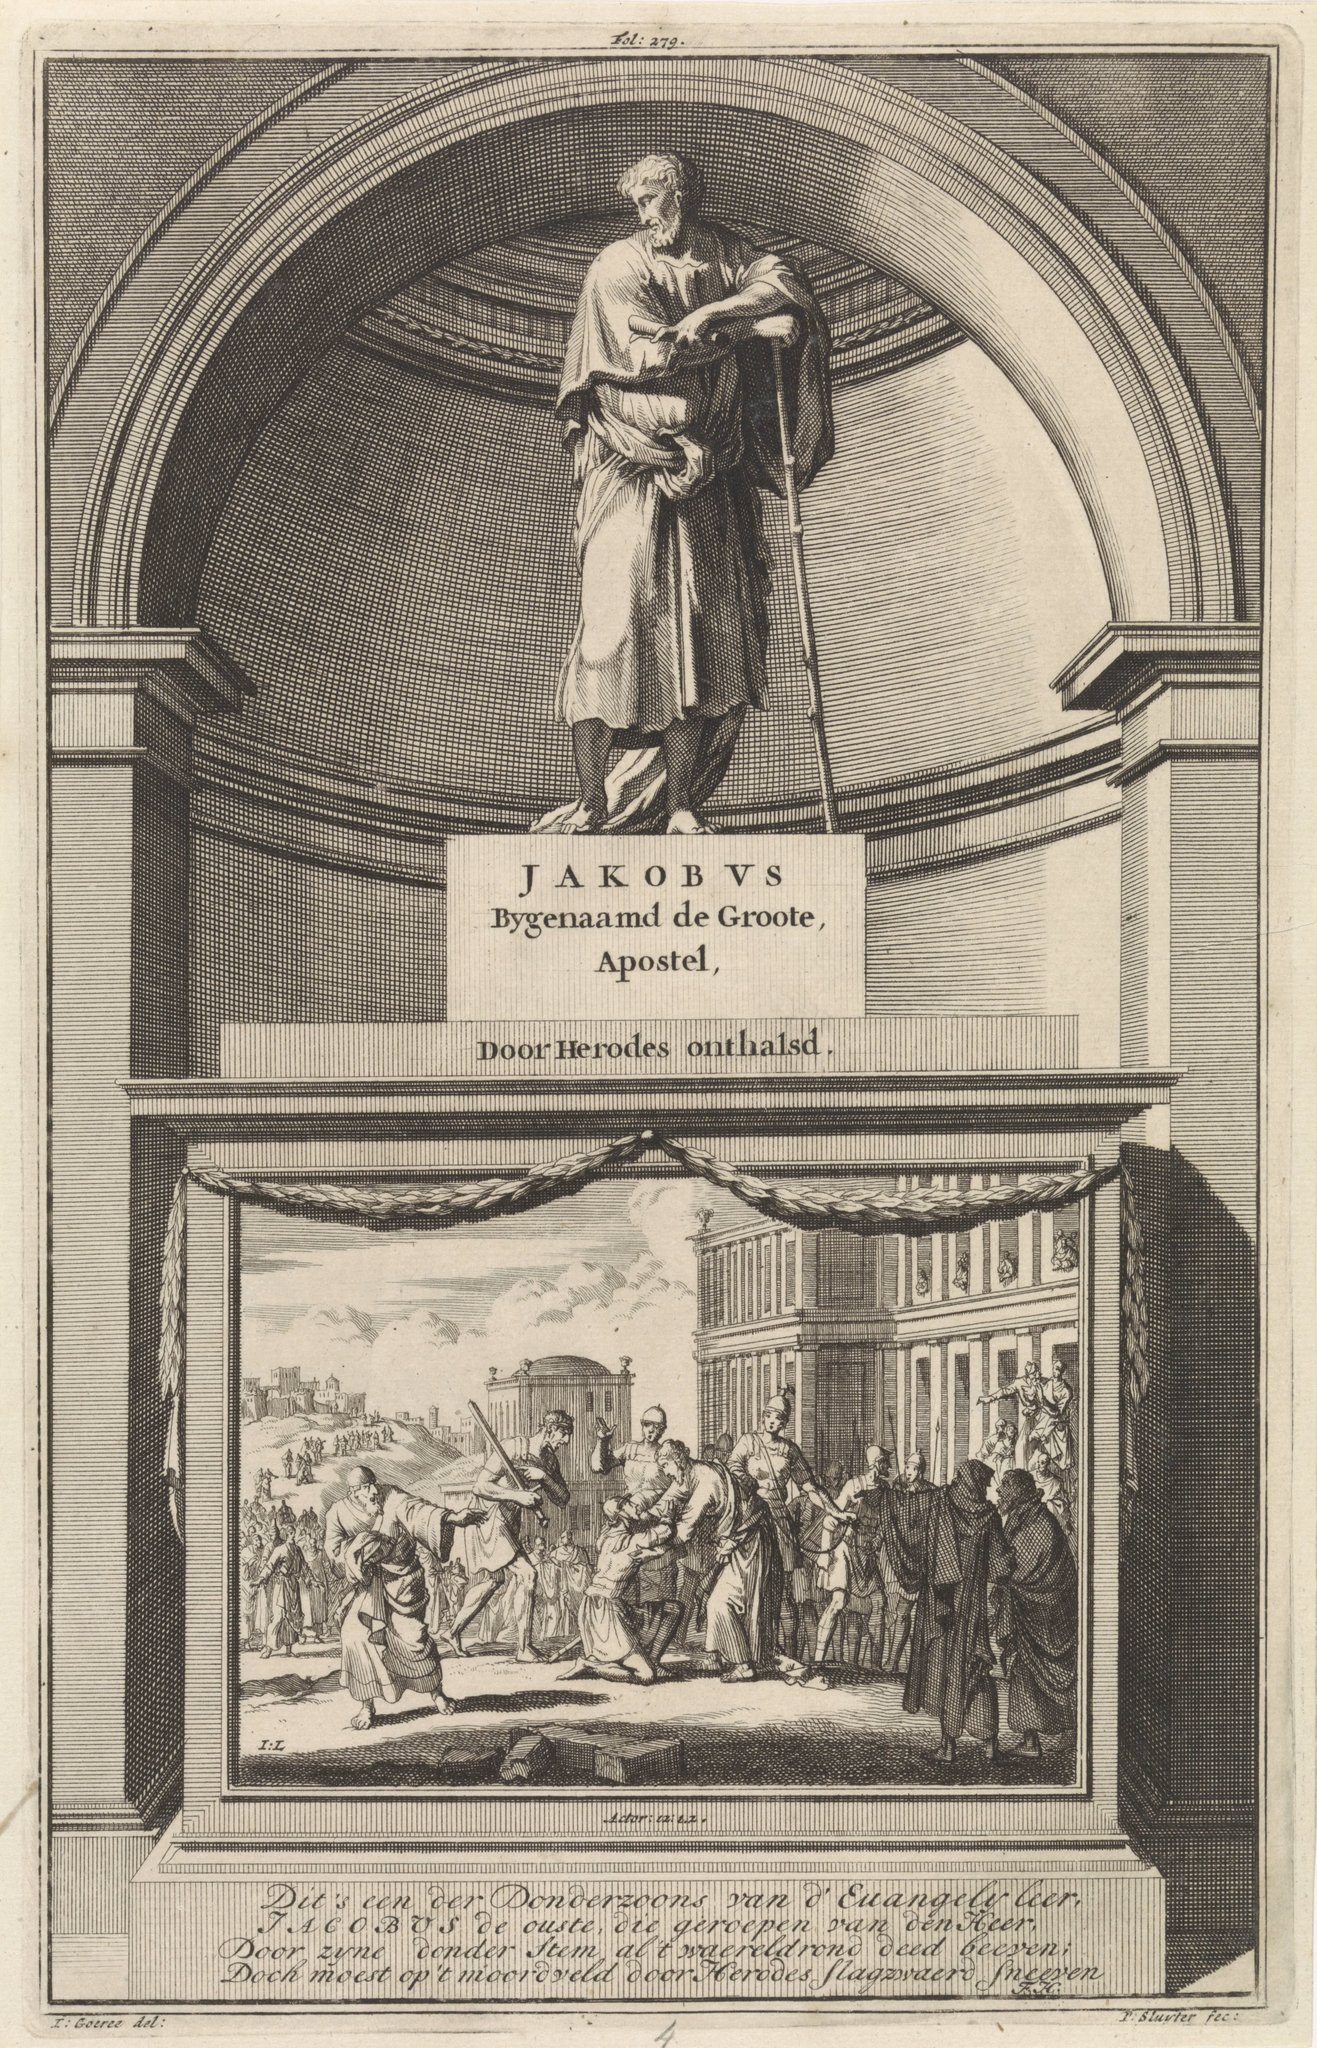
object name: book illustration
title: Apostel Jakobus de Meerdere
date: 1698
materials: paper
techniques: engraving, etching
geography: amsterdam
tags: beheading of james, the apostle james the great; possible attributes: book, pilgrim's cloak, hat, shell, staff, and wallet, scroll, sword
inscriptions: collector's mark: Lugt 2228, number: ‘4’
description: De apostel Jakobus de Meerdere, steunend op een wandelstaf en in de hand een rol papier. Jakobus staat op een sokkel waar op de voorzijde zijn onthoofding in beeld is gebracht. Prent middenboven gemerkt: Fol: 279.